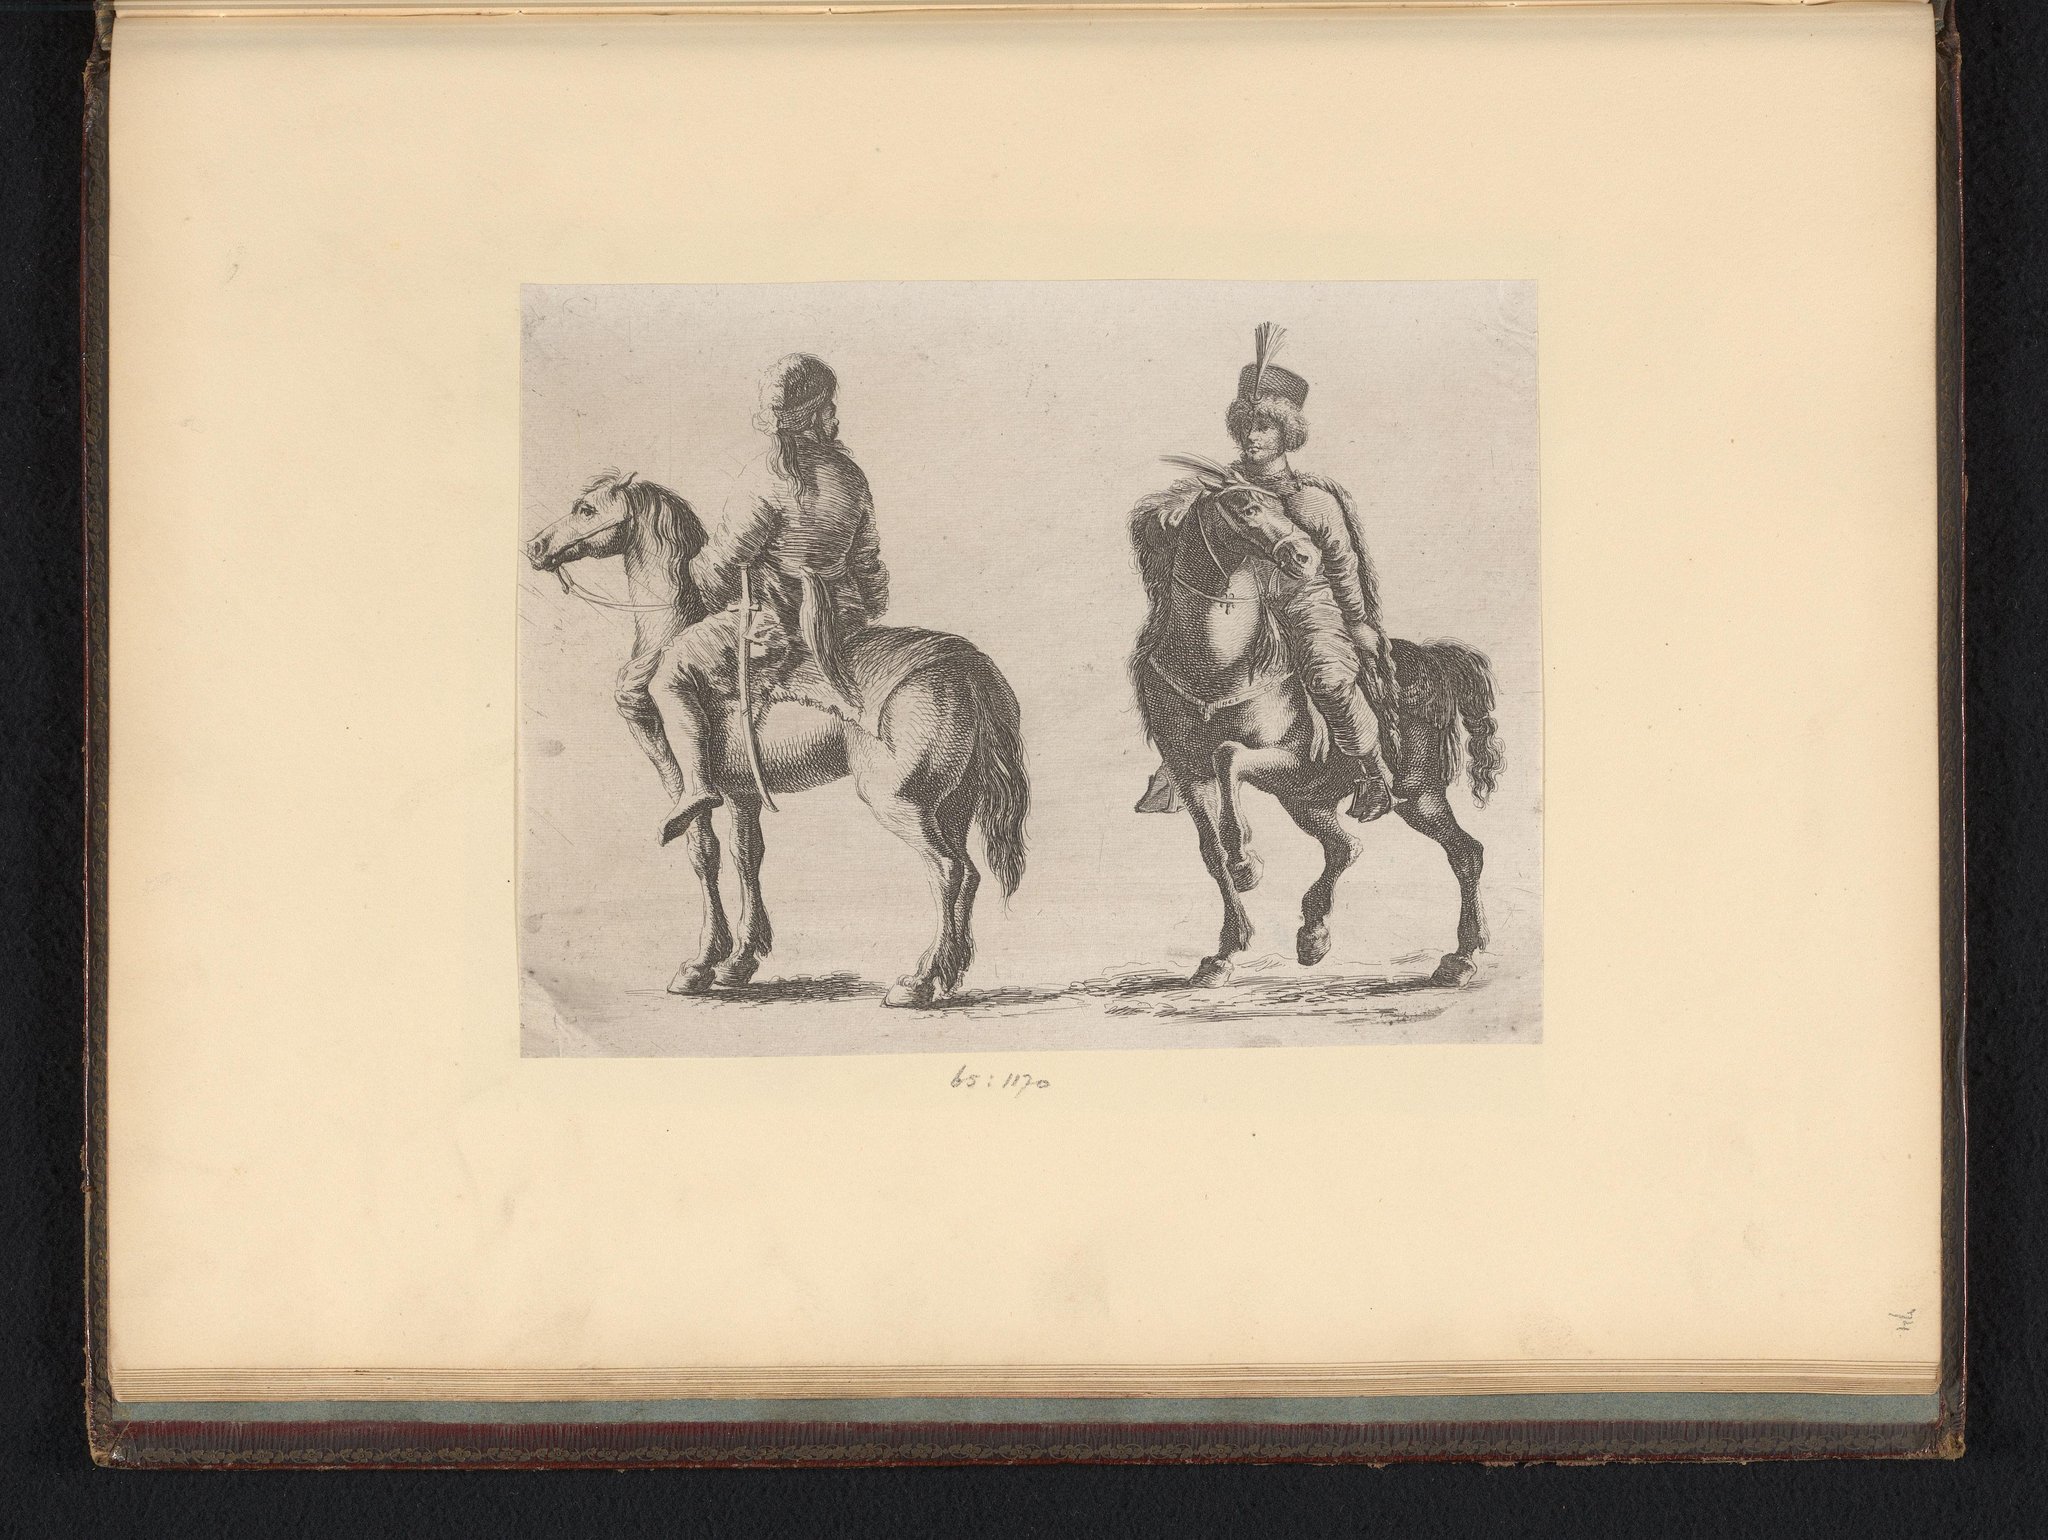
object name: print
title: Twee ruiters, mogelijk Pools en Hongaars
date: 1805-1844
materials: paper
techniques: etching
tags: riding a horse, ass, or mule; rider, horseman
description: Prent maakt mogelijk deel uit van een serie van 200 prenten. Deze serie is onder de titel 'A Collection of two hundred original etchings' voor het eerst uitgegeven door J.M. Greery in 1816.